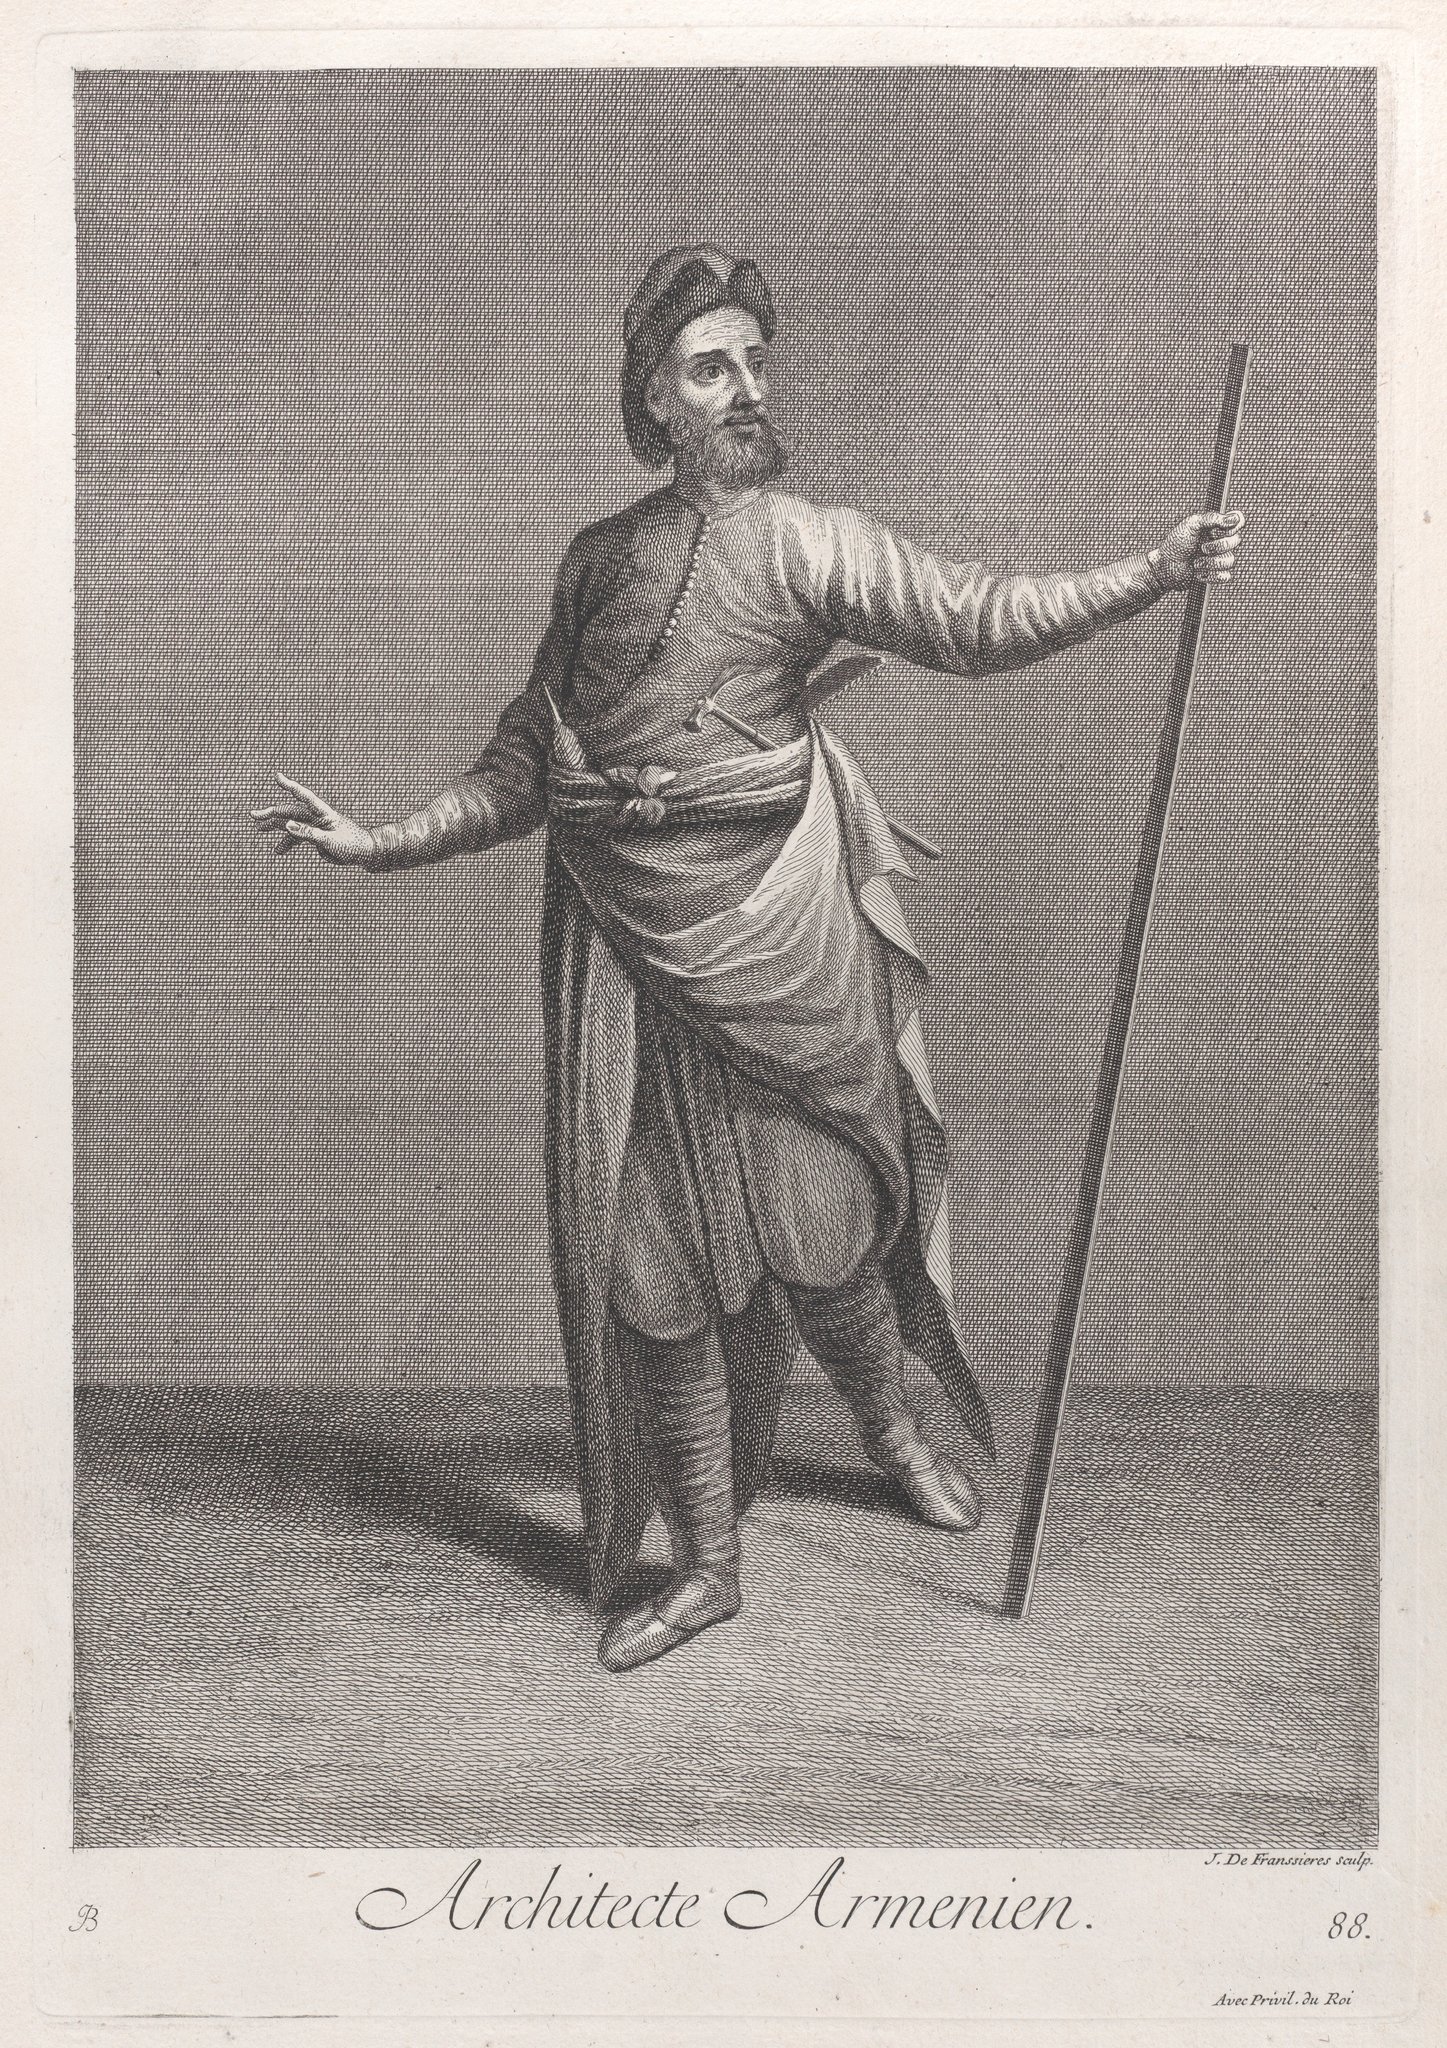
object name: print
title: Architecte Armenien, plate 88 from "Recueil de cent estampes représentent differentes nations du Levant"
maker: jean baptiste vanmour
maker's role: artist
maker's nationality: french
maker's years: 1671-1737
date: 1714-1715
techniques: engraving, etching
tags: men